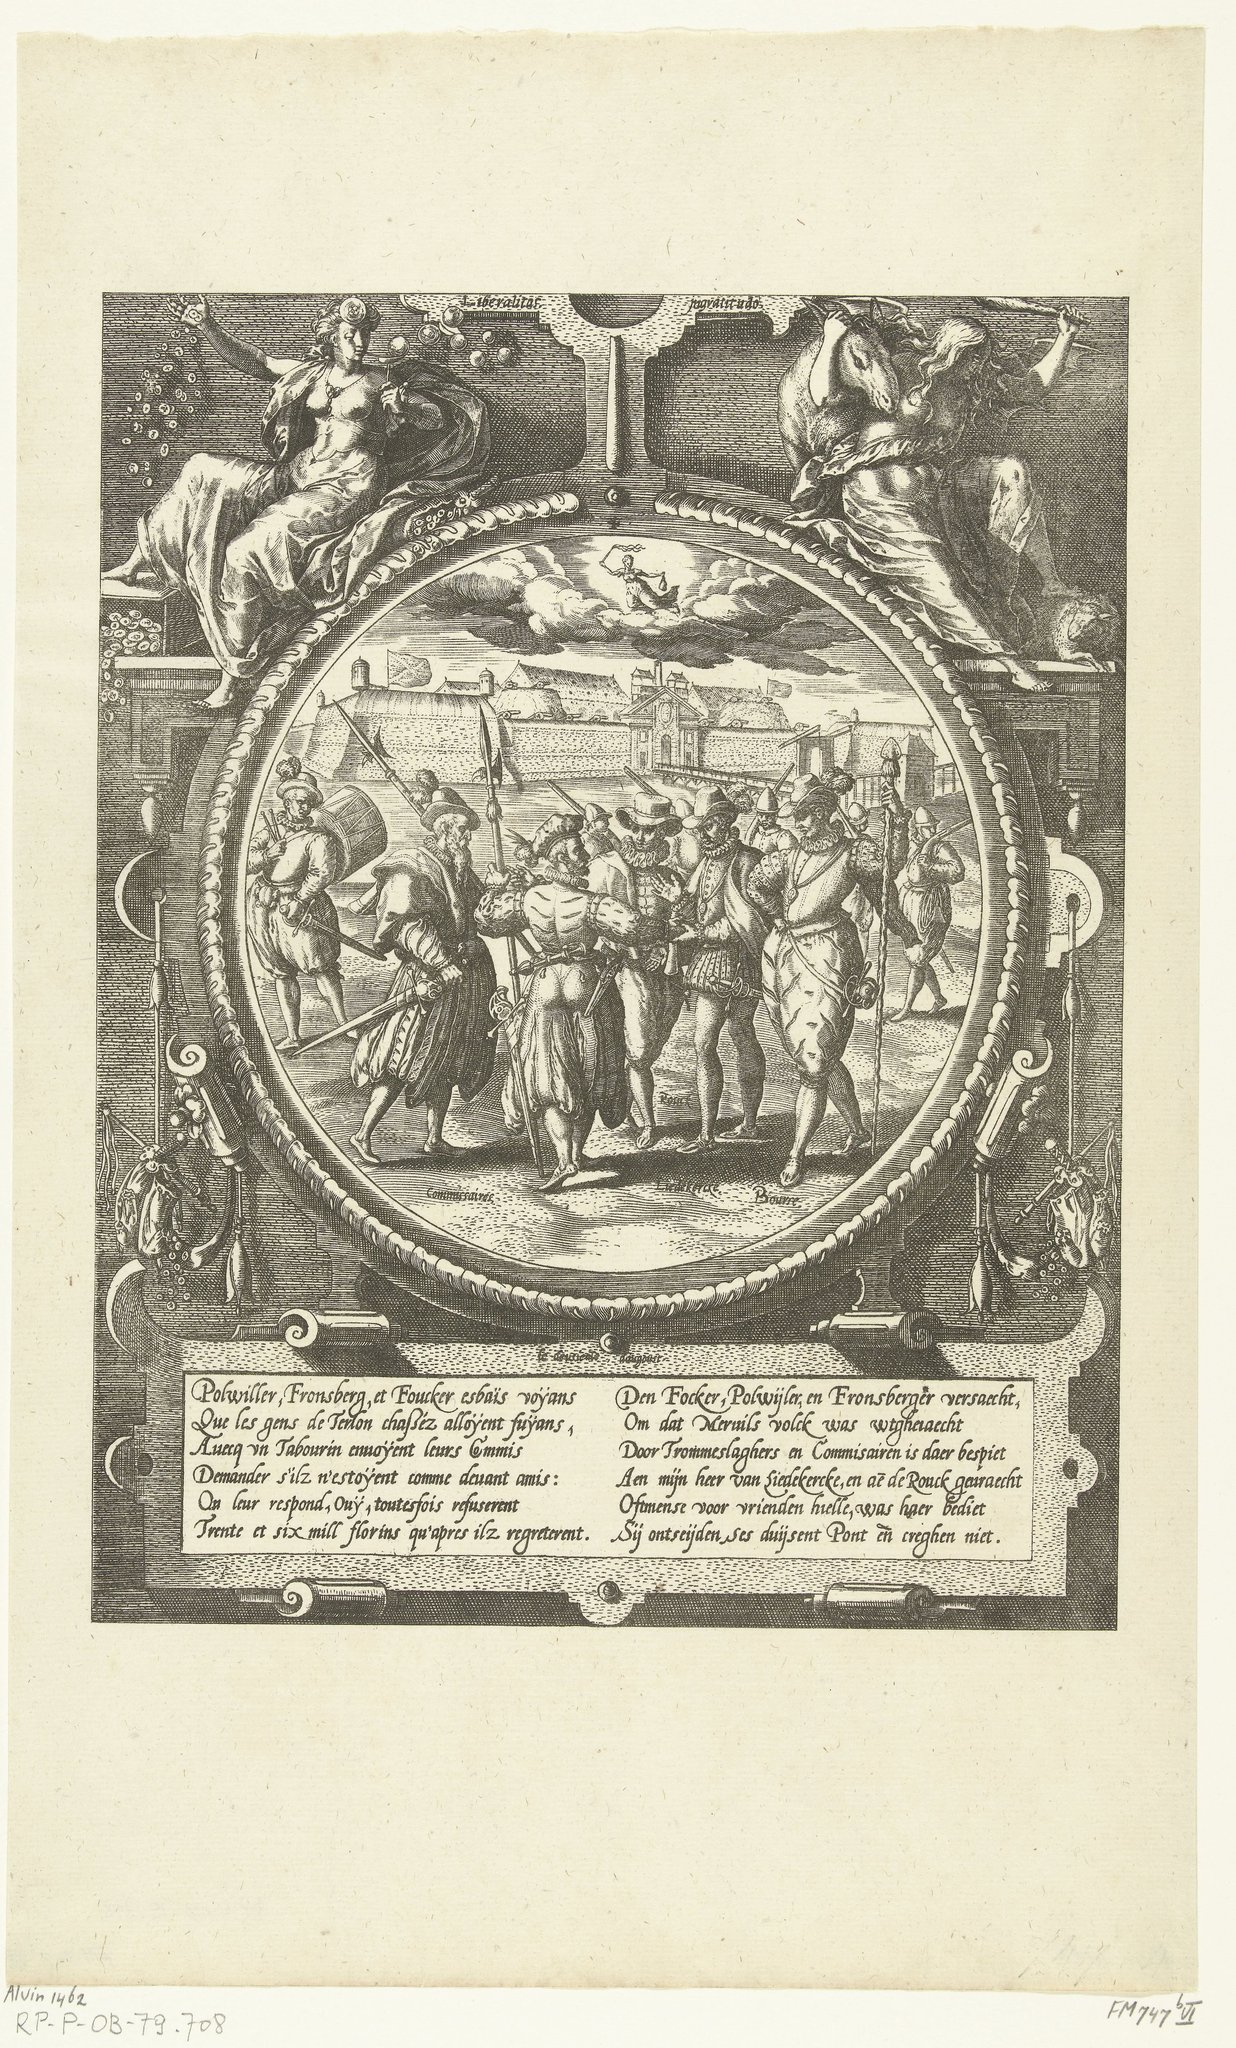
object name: historical object representation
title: Reproducties van de medaillons met de verovering van de citadel van Antwerpen in 1577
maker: william stirling maxwell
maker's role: politician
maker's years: 1818-1878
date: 1877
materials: paper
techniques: photolithography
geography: great britain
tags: negotiations for truce, ingratitude; 'ingratitudine' (ripa), generosity, liberality; 'generosità', 'liberalità' (ripa), punishment; 'castigo', 'pena', 'punitione' (ripa)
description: Reproductie van de prent met de onderhandelingen tussen Liedekercke, Roeck en Bourse en de Duitse commandanten over een afkoopsom voor het vertrek van het Duitse garnizoen, 2 augustus 1577. Groep mannen staande in overleg, op de achtergrond de citadel. In de wolken de personificatie van Gods bestraffing. Voorstelling in een rond medaillon met ornamentele allegorische omlijsting met bovenaan de zittende vrouwelijke personificaties van Vrijgevigheid (Liberalitas) en Ondankbaarheid (Ingratitudo). Onderaan een cartouche met 2 verzen van elk 6 regels in het Frans en Nederlands.